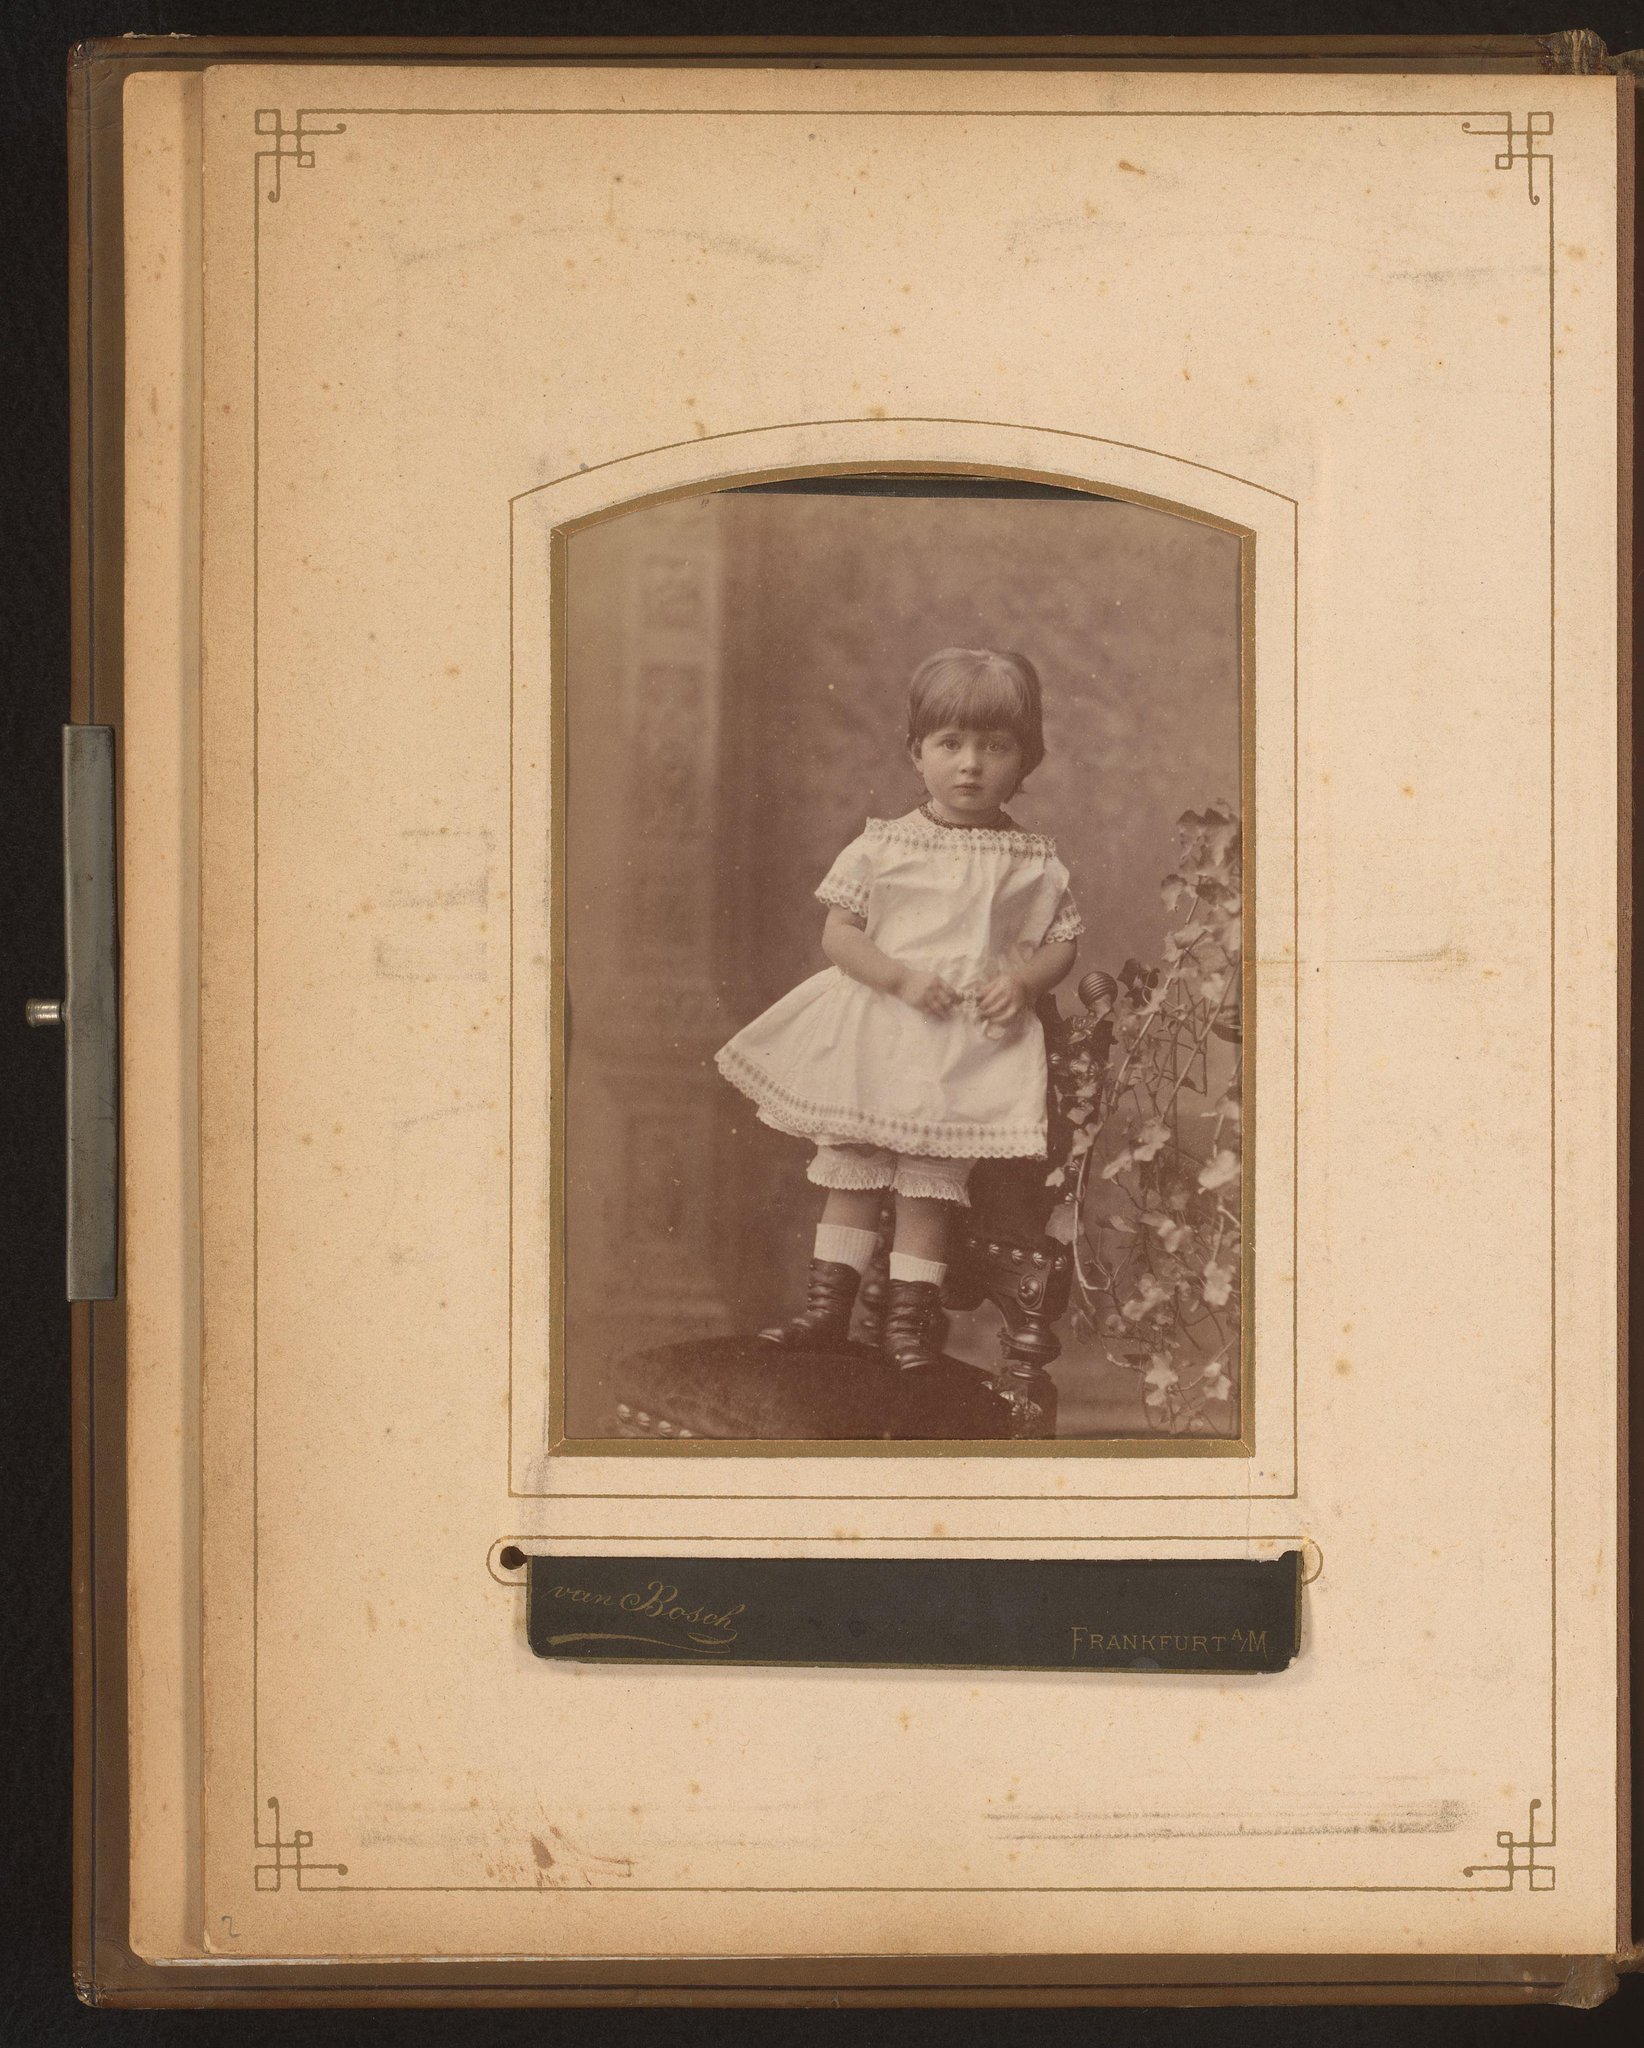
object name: photograph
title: Portret van een meisje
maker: otto van bosch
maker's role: fotograaf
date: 1860-1890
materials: cardboard, photographic support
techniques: albumen print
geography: frankfurt am main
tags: girl (child between toddler and youth)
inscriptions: inscription: ‘Otto van Bosch/ Köngl: Hofphotograph/ Frankfurt a/M/ Kiserstrasse 6 (...)’